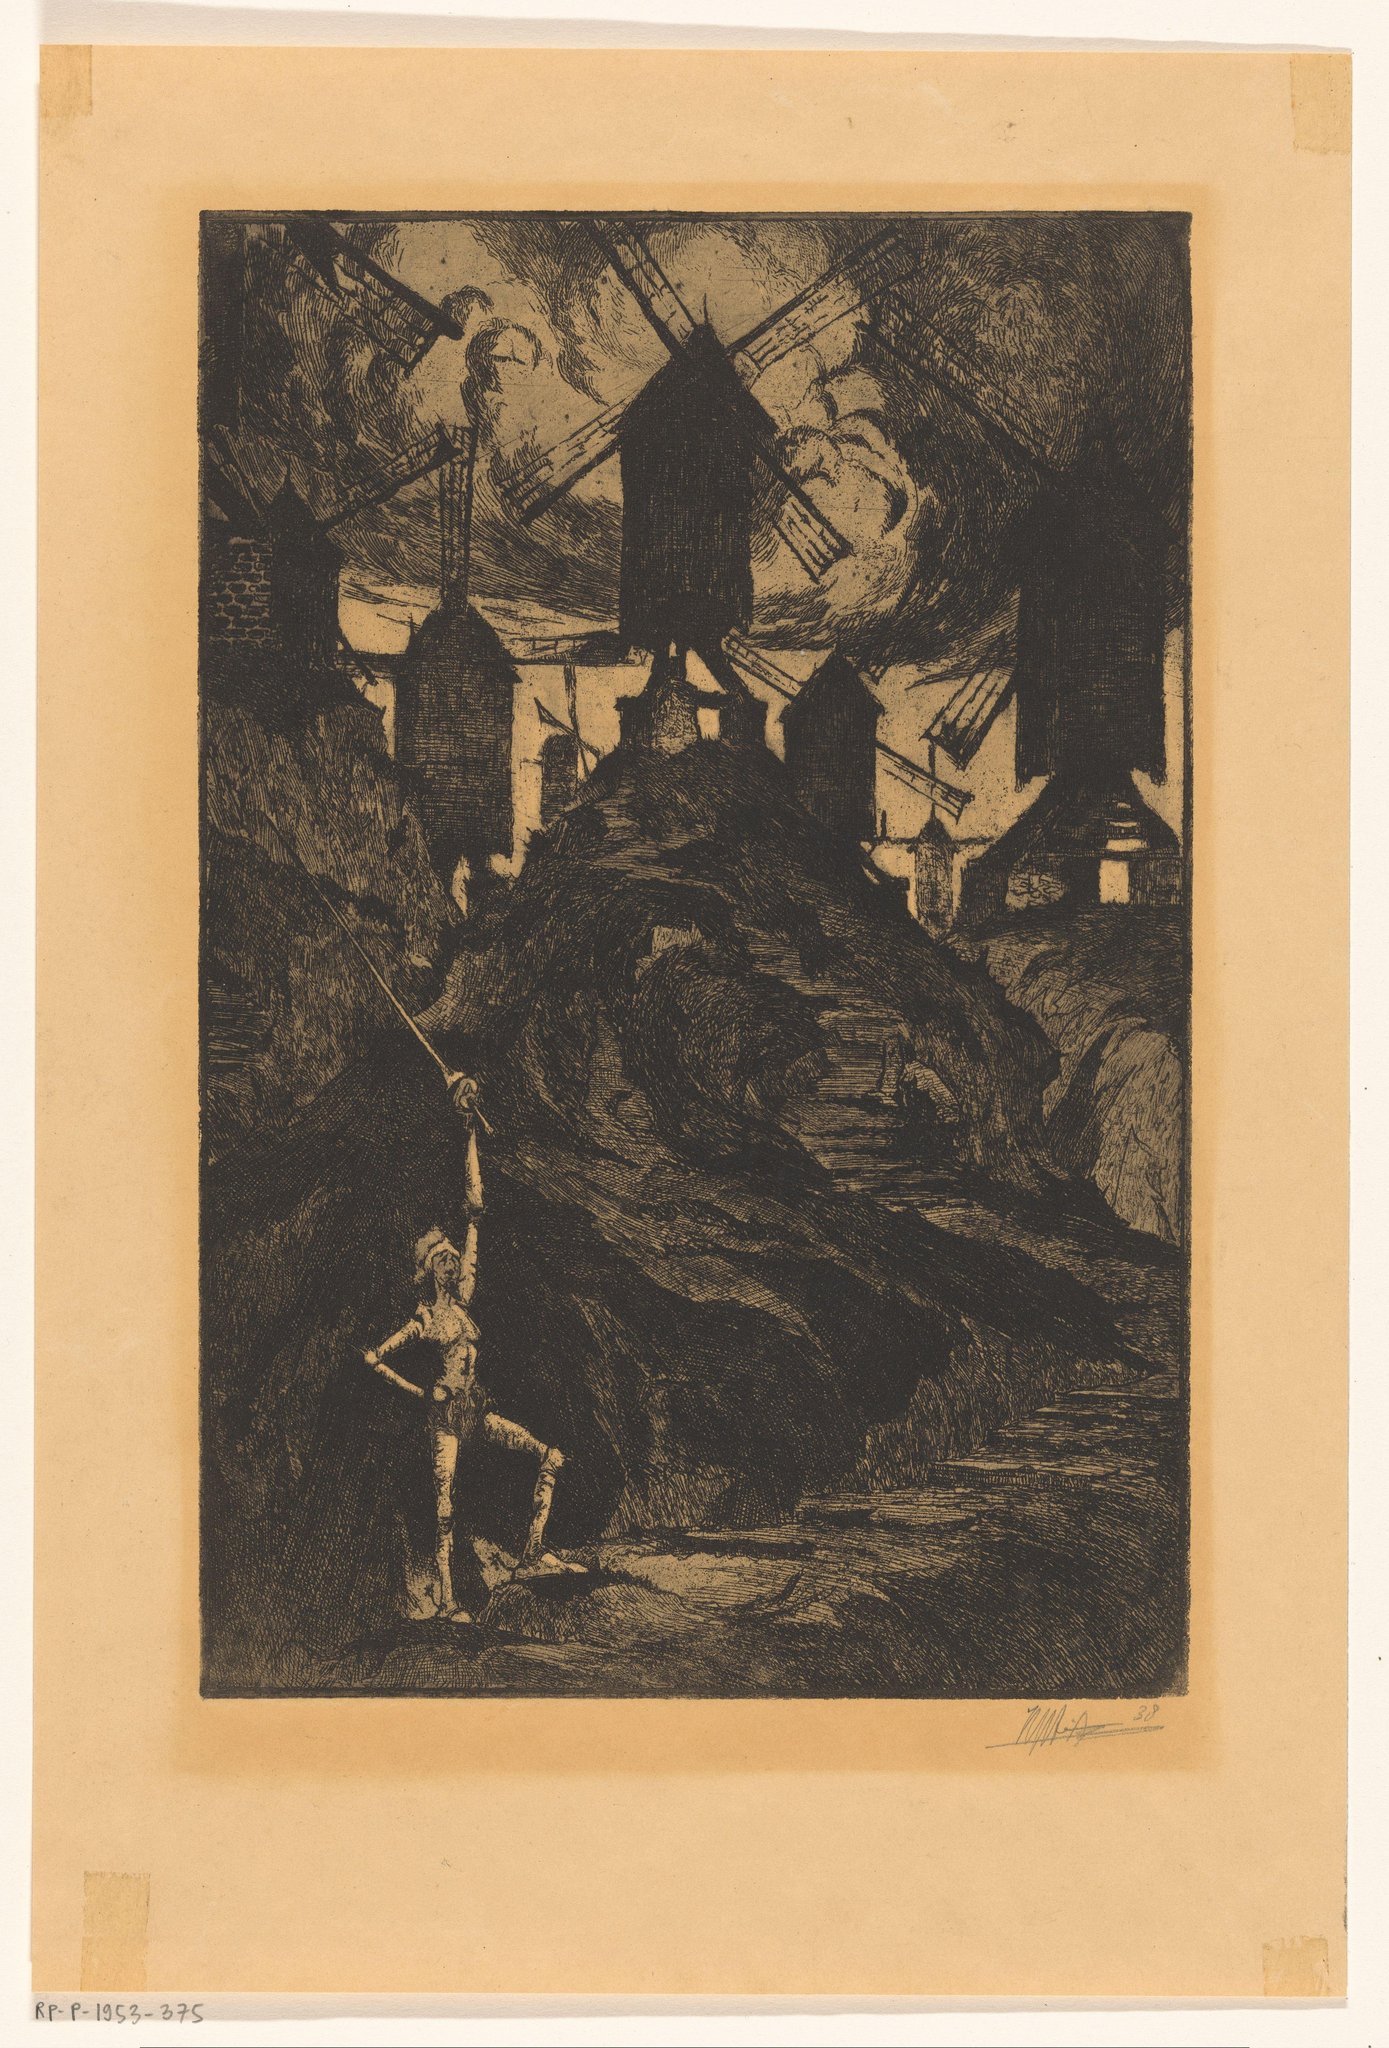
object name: print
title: Don Quichot en de windmolens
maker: kornelis jacobus huineman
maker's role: draughtsman, print maker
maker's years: 1886-1952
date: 1938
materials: paper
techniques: etching, intaglio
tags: helved weapons, polearms (for striking, hacking, thrusting): lance, windmill in landscape, don quixote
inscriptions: collector's mark: Lugt 2228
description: Links op de voorgrond Don Quichot die zijn lans in de lucht steekt. Op de achtergrond de windmolens die hij aanziet voor reuzen.